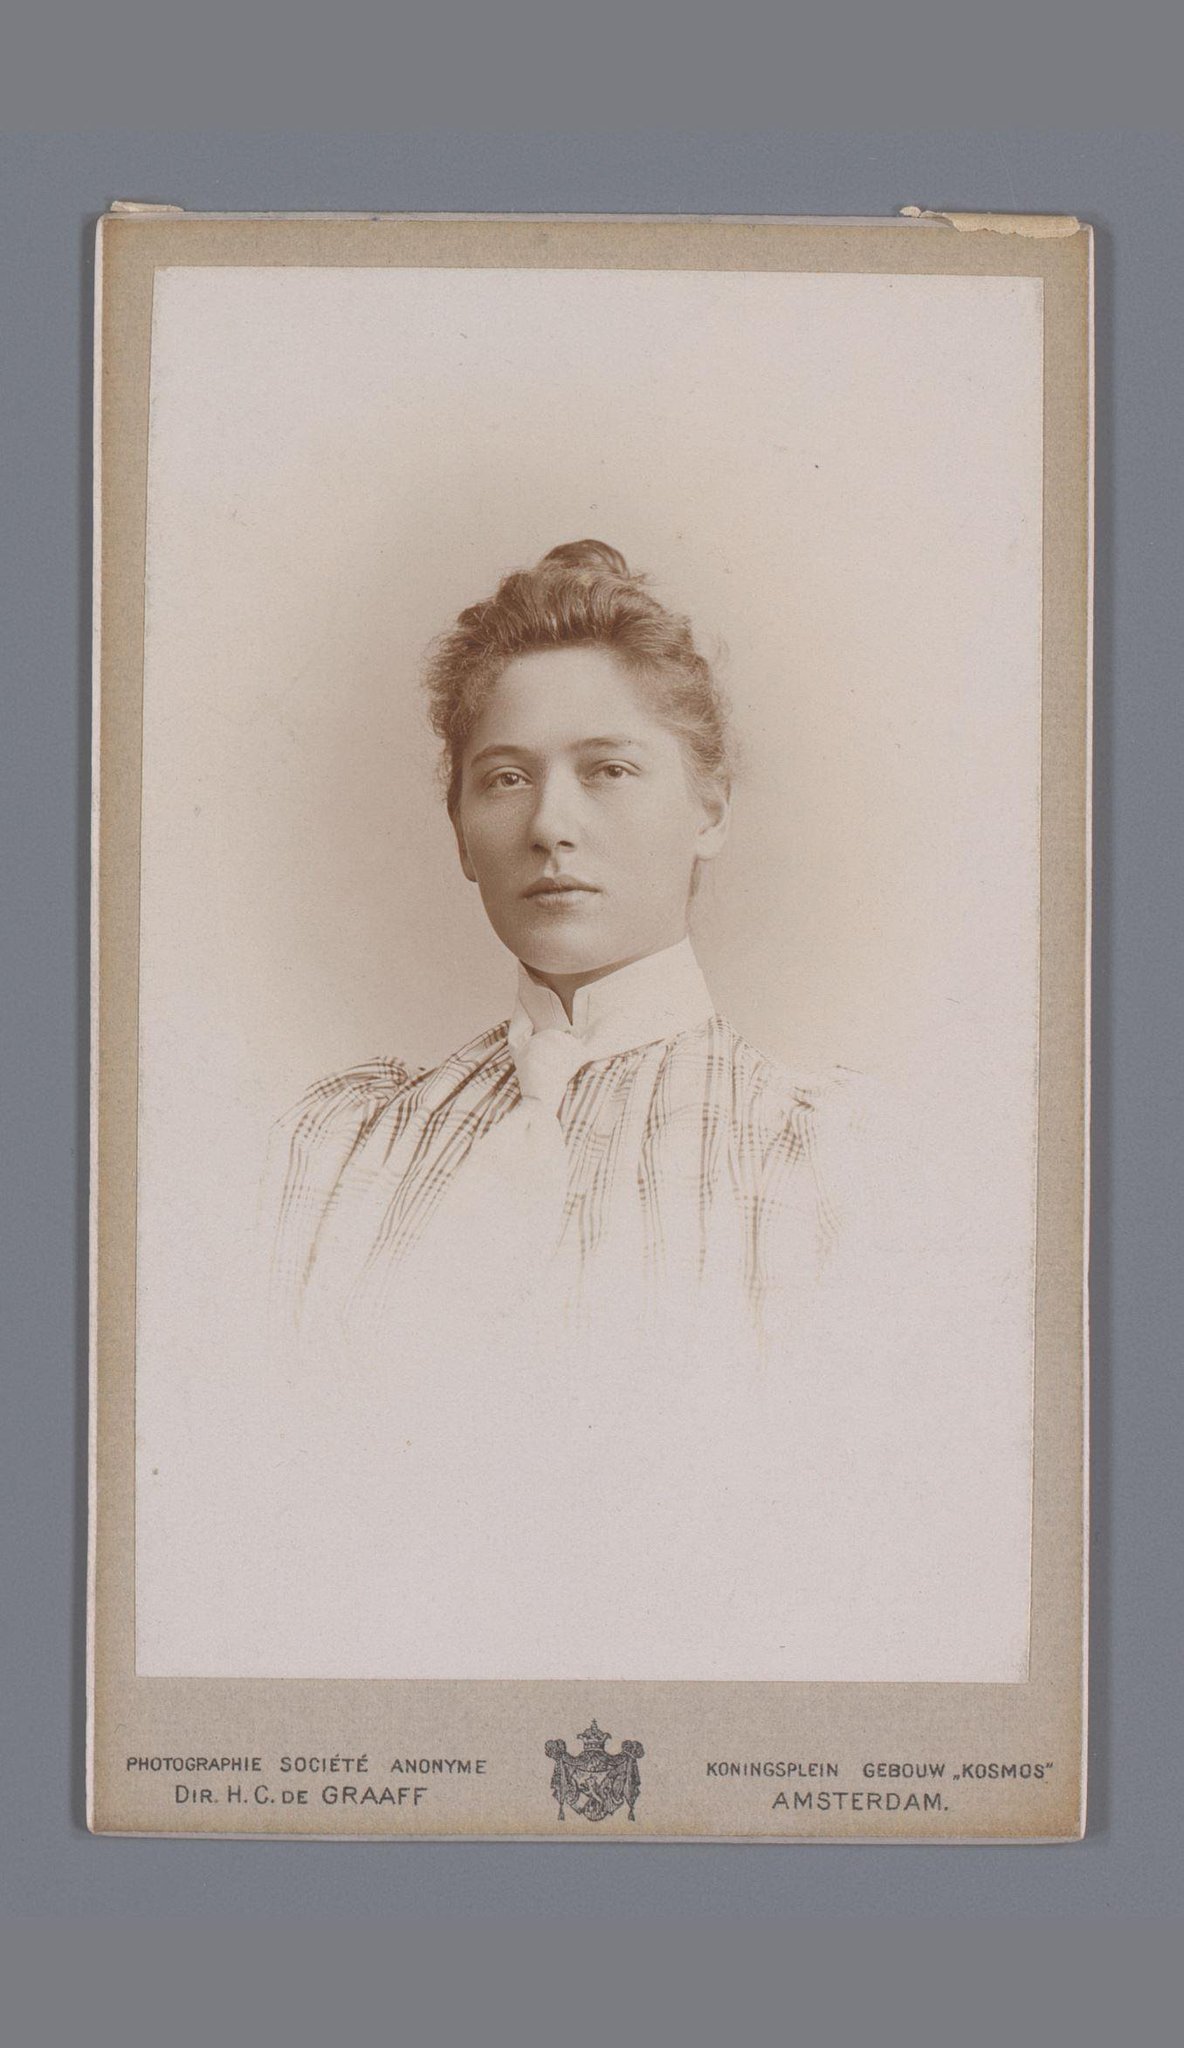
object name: carte de visite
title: Portret van Christina Maria Lucie Langhout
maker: h.c. de graaff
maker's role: fotograaf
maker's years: 1853-1932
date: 1882-1922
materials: cardboard, photographic support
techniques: collodion silver print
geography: amsterdam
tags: historical persons, amsterdam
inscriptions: annotation: ‘Christine Langhout’, workshop stamp: ‘Photographie Société anonyme/ Dir. H.C. de Graaff/ Koningsplein gebouw Kosmos, Amsterdam’